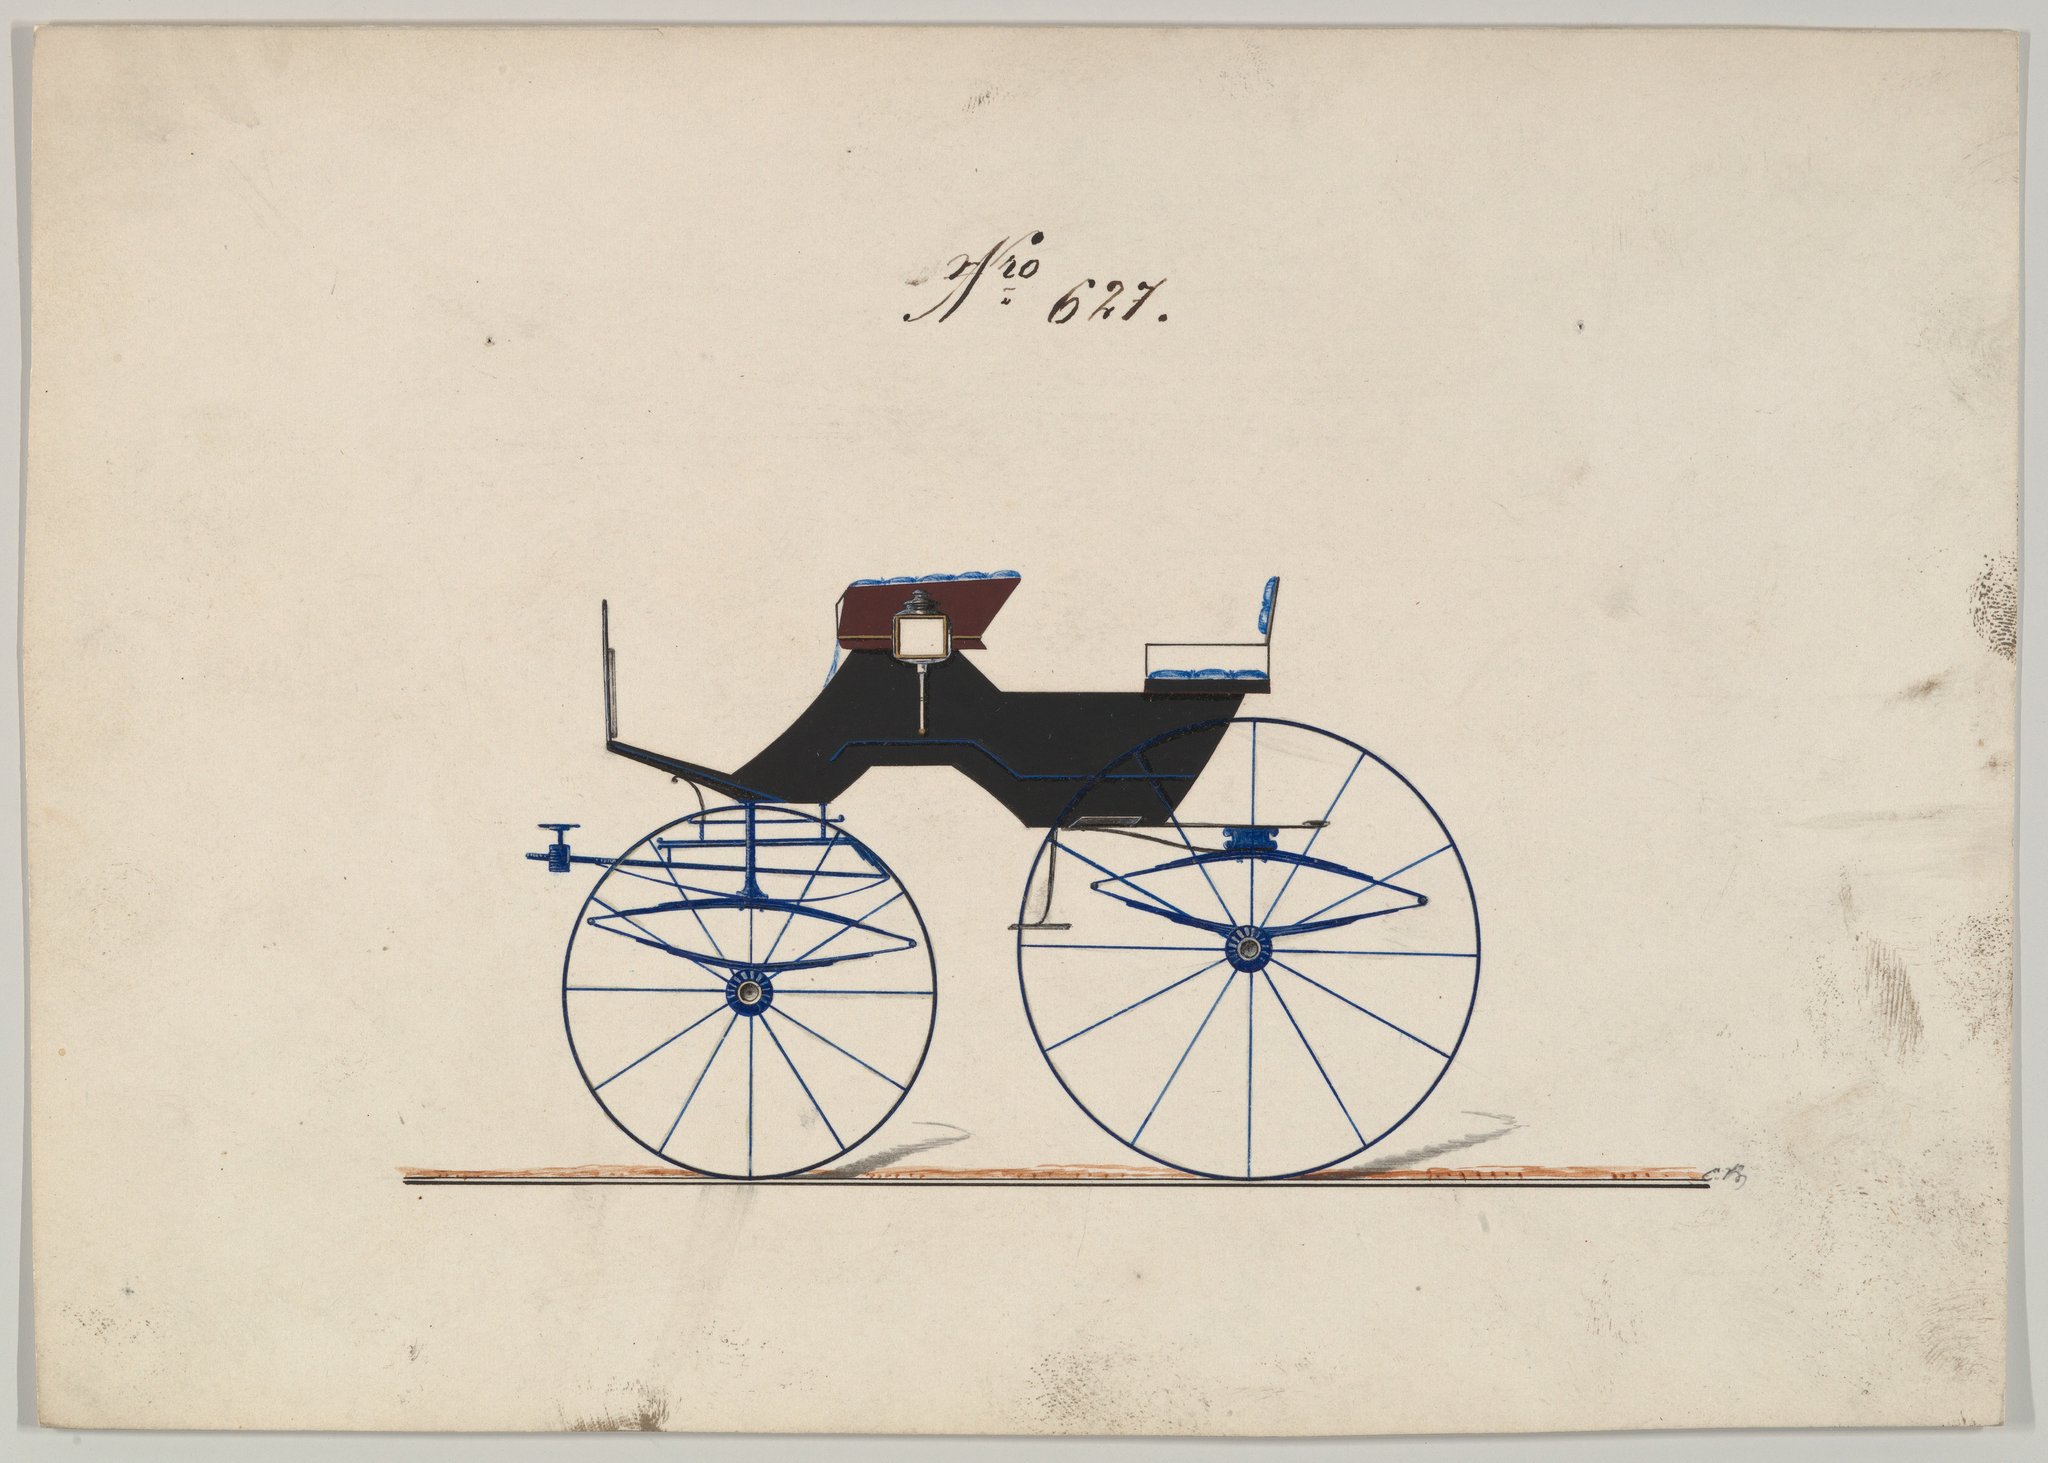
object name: drawing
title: Dog Cart Phaeton #627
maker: brewster & co.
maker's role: manufacturer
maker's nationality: american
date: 1850-1870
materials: gouache, gum arabic, ink, watercolor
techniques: pen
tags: carriages